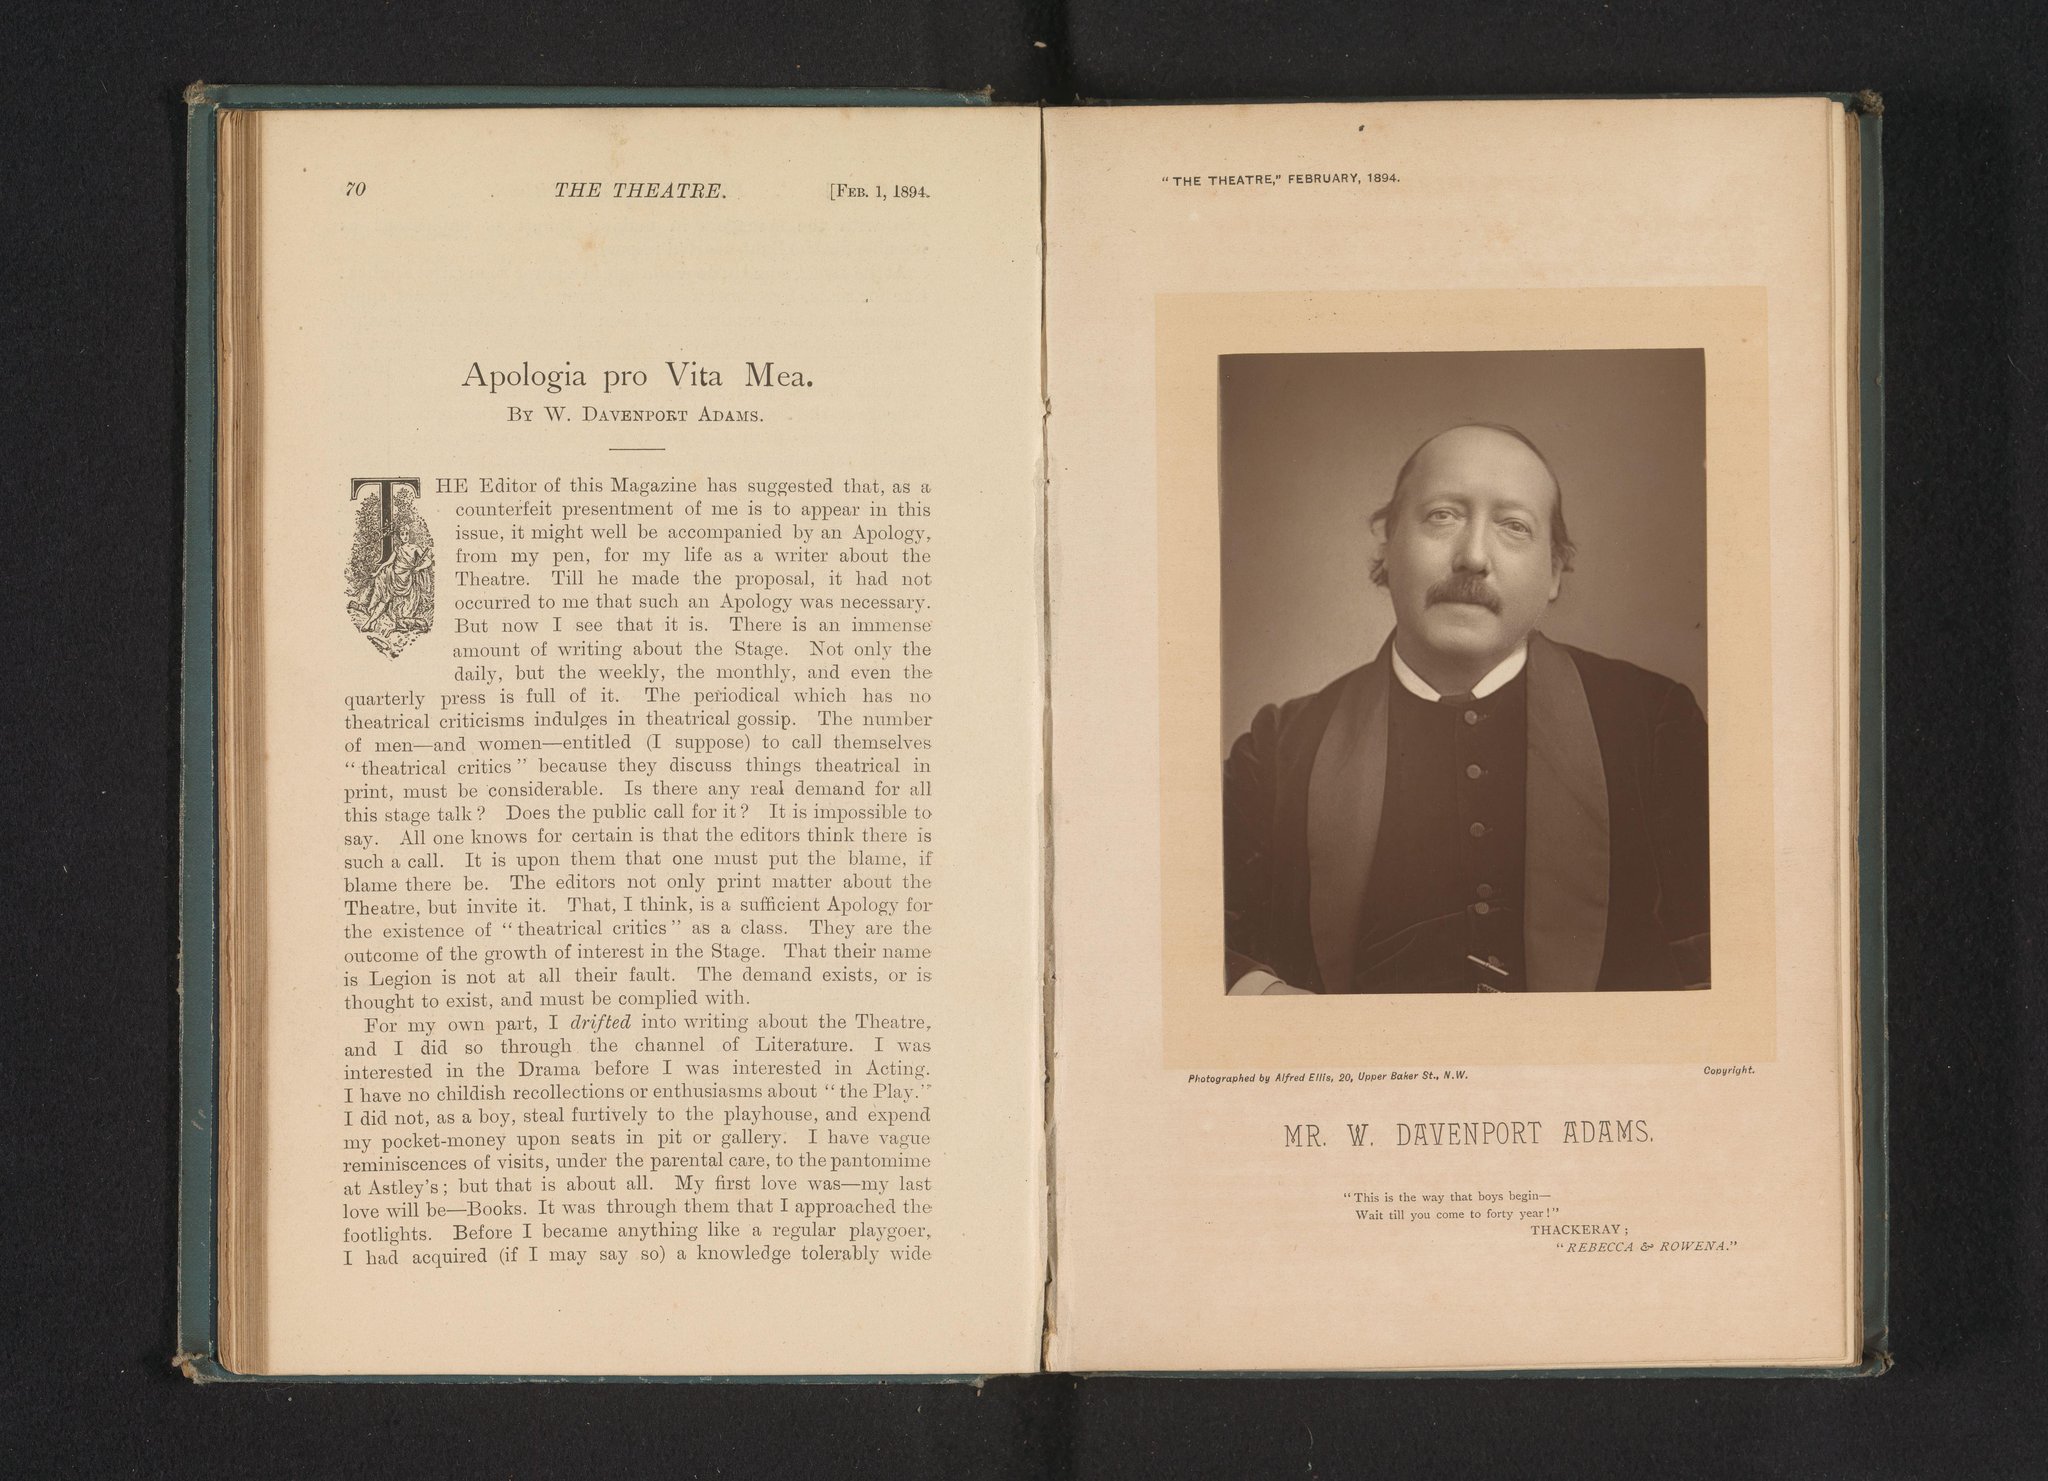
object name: page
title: Mr. W. Davenport Adams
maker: alfred ellis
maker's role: fotograaf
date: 1889-1894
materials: paper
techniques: carbon print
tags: adult man, historical persons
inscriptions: inscription: ‘'The Theatre' February, 1894.’, inscription: ‘'This is the way that boys begin -/ Wait till you come to forty year!'/ Thackeray :/ 'Rebecca & Rowena"’